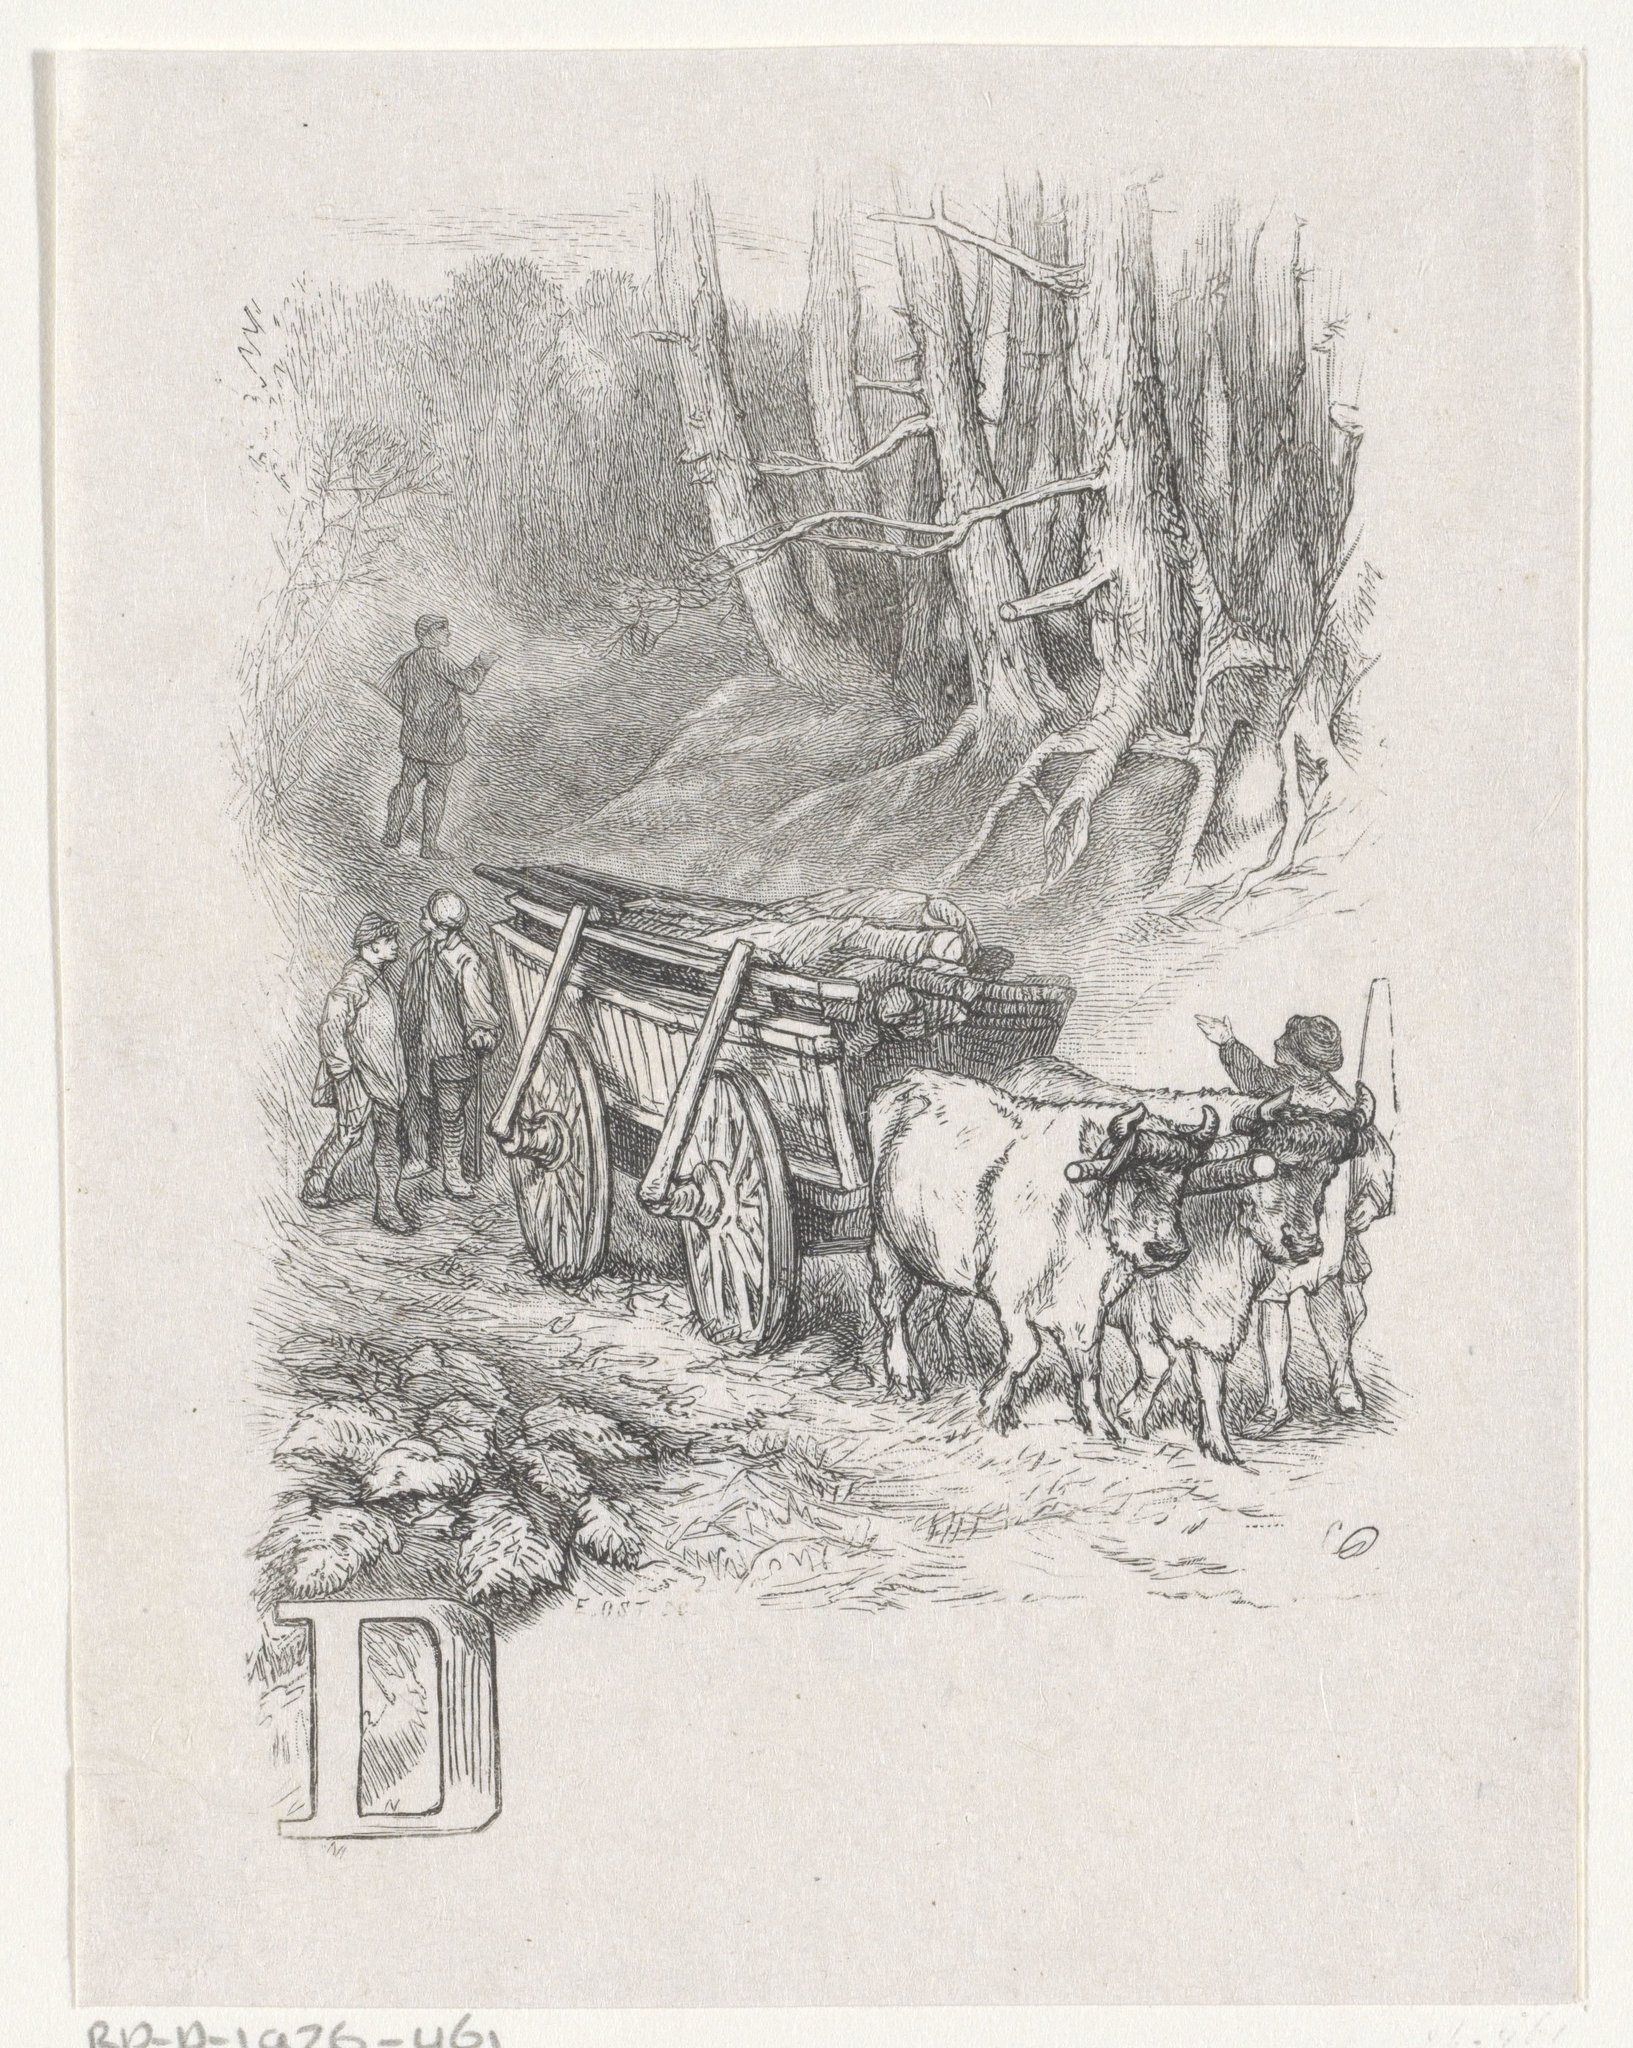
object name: print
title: Letter D en een landschap met vier mannen en een ossenwagen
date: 1856-1926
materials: paper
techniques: engraving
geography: belgium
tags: fancy letters, ox, four-wheeled vehicle drawn by two animals, forest path or lane (+ landscape with figures, staffage)